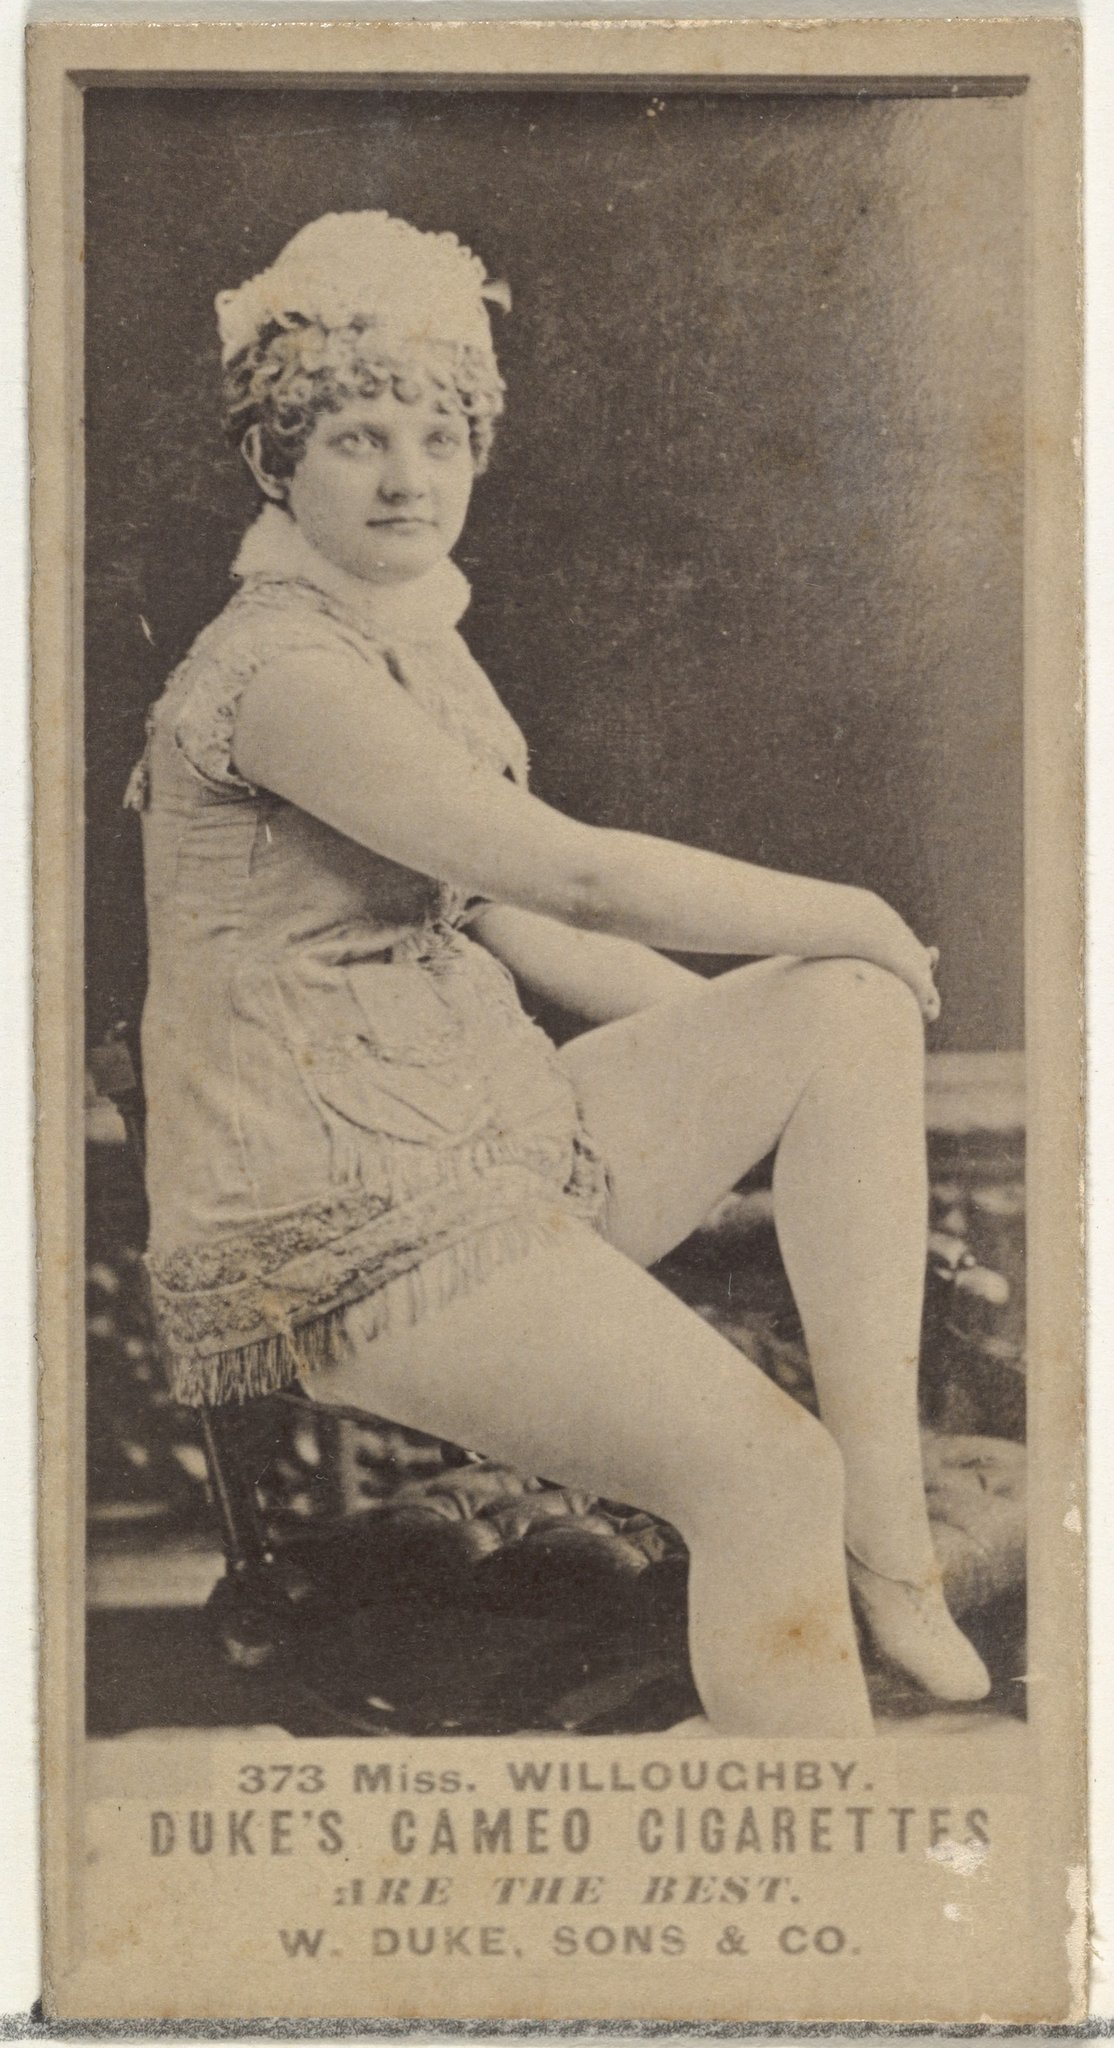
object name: photograph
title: Card Number 373, Miss Willoughby, from the Actors and Actresses series (N145-5) issued by Duke Sons & Co. to promote Cameo Cigarettes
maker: w. duke, sons & co.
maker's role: publisher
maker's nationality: american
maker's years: 1870-1920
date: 1880-1889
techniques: albumen silver print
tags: portraits,women,actresses